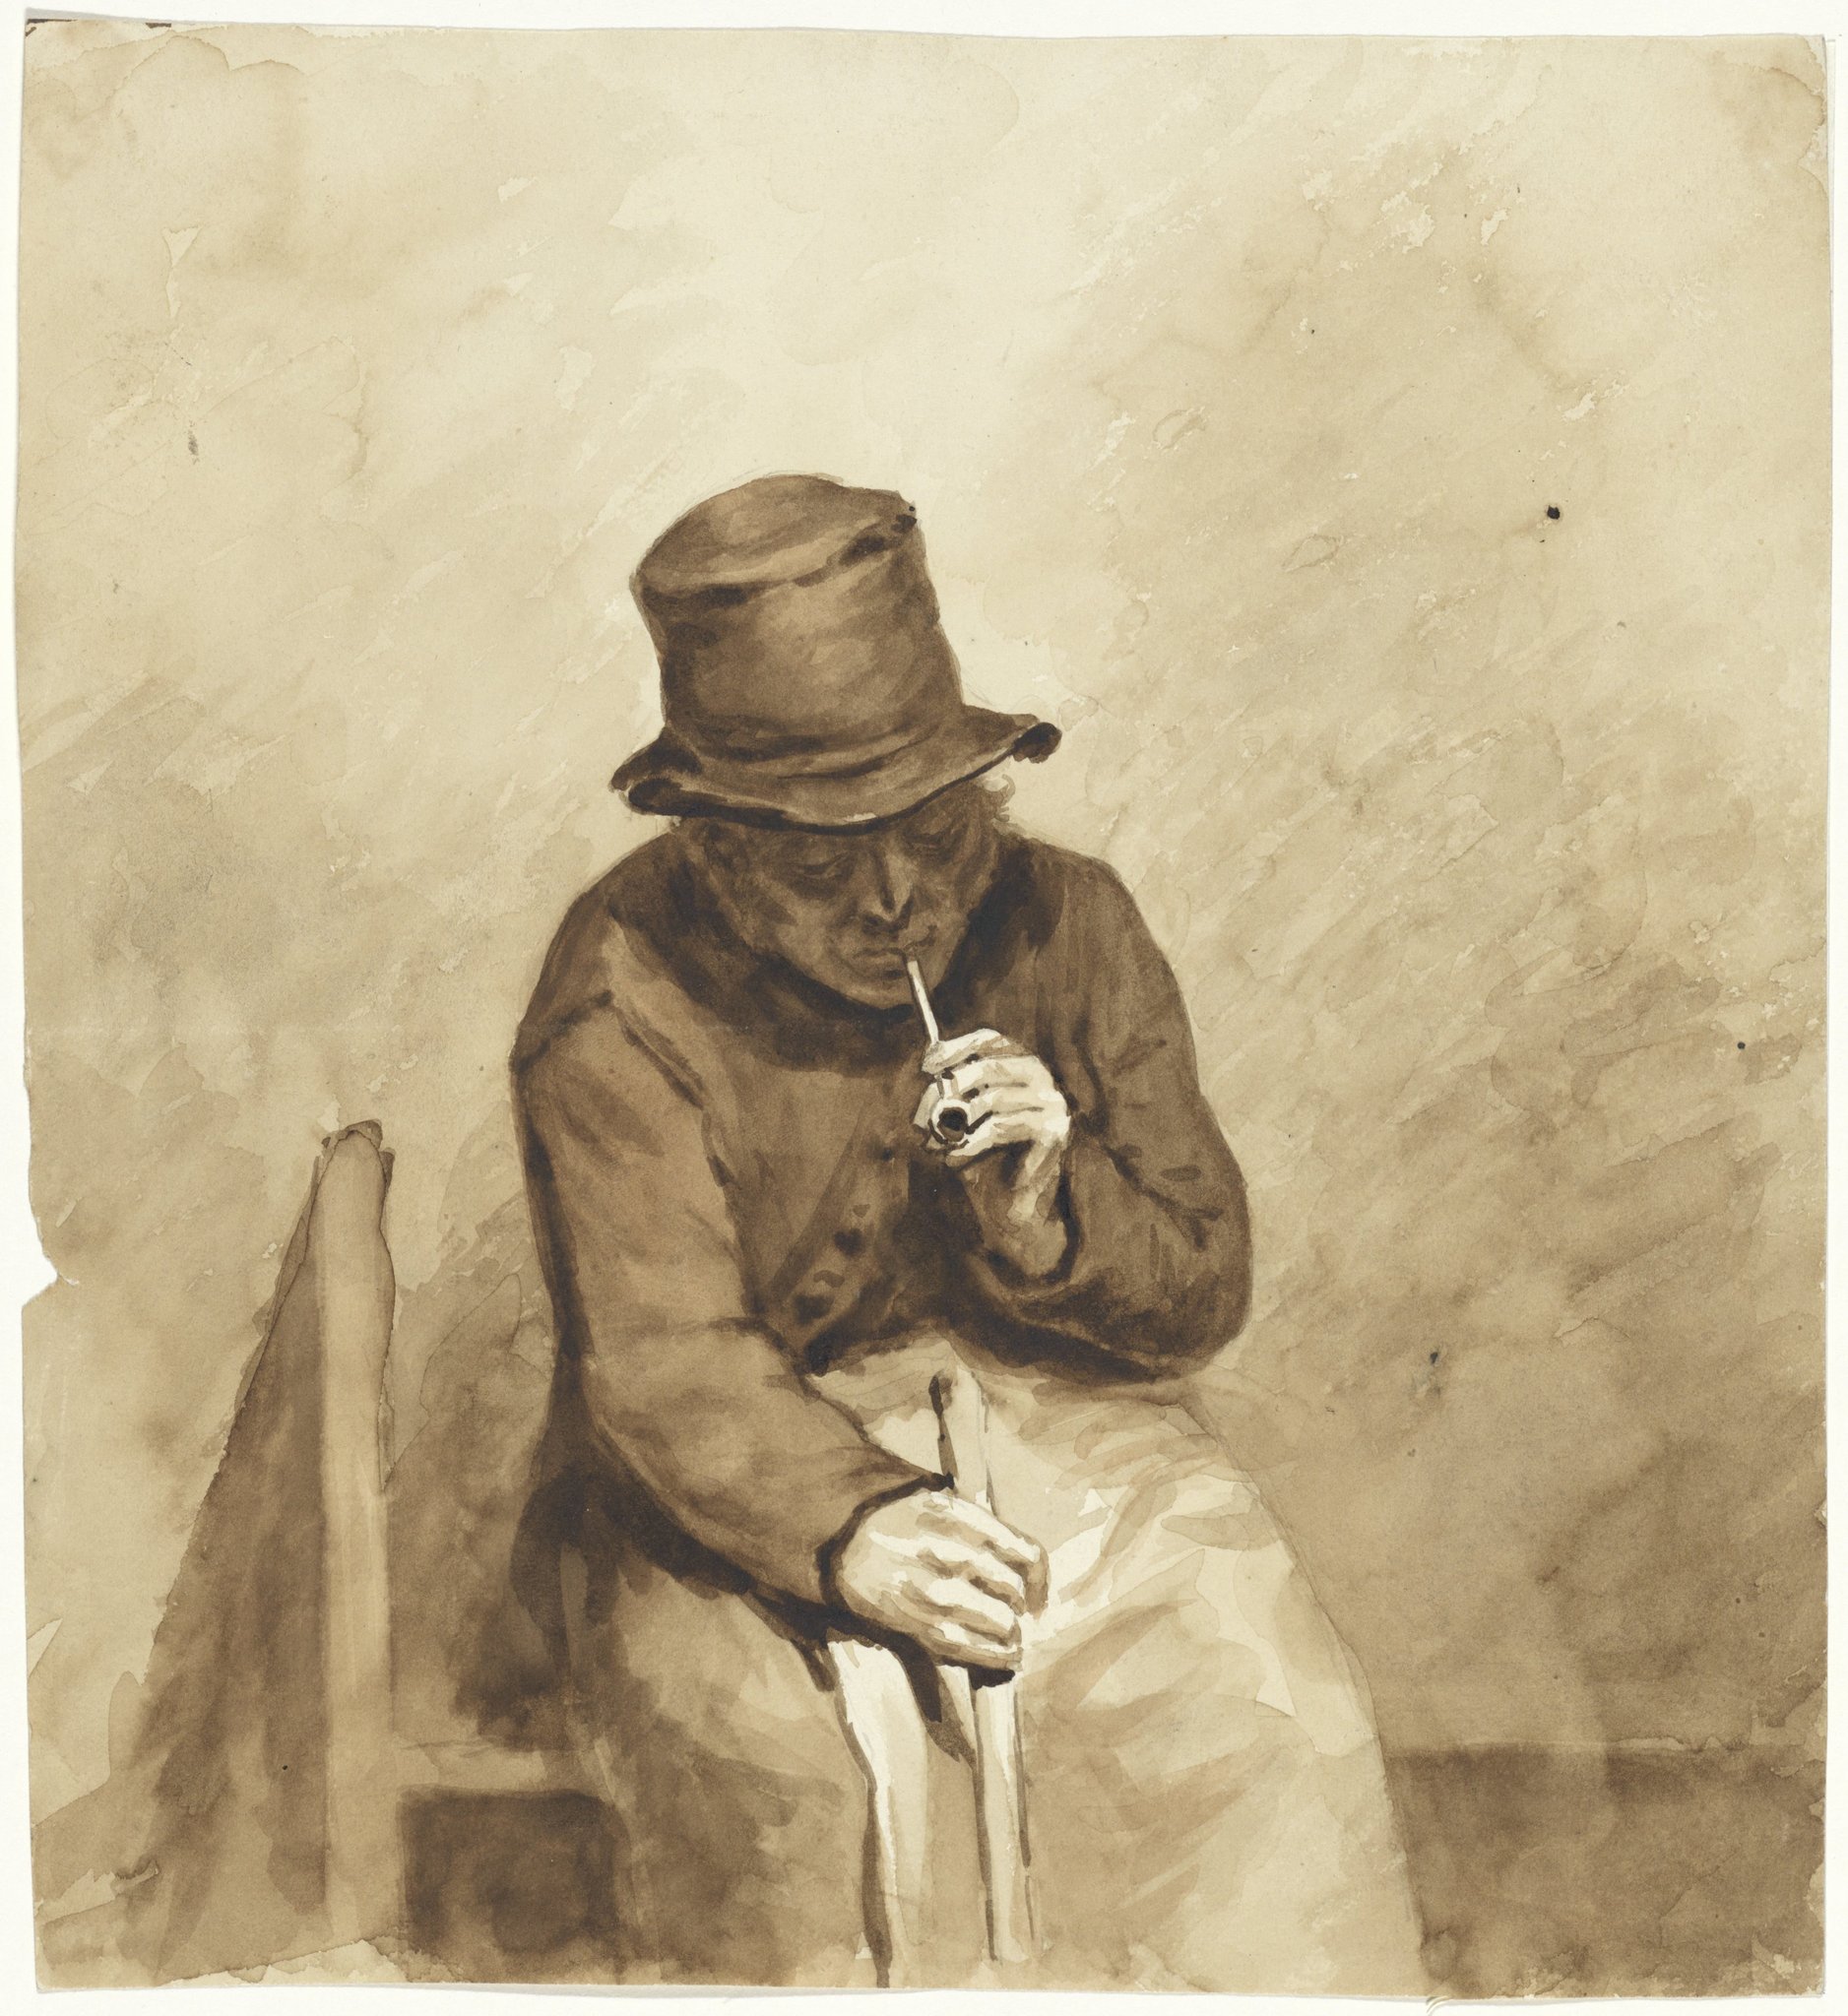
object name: drawing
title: Zittende rokende man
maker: pieter van loon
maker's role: draughtsman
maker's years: 1801-1873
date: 1811-1873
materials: paper, pencil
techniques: brush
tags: pipe ~ tobacco (+ taking (particular) foodstuffs: eating, drinking, smoking, chewing, etc.)